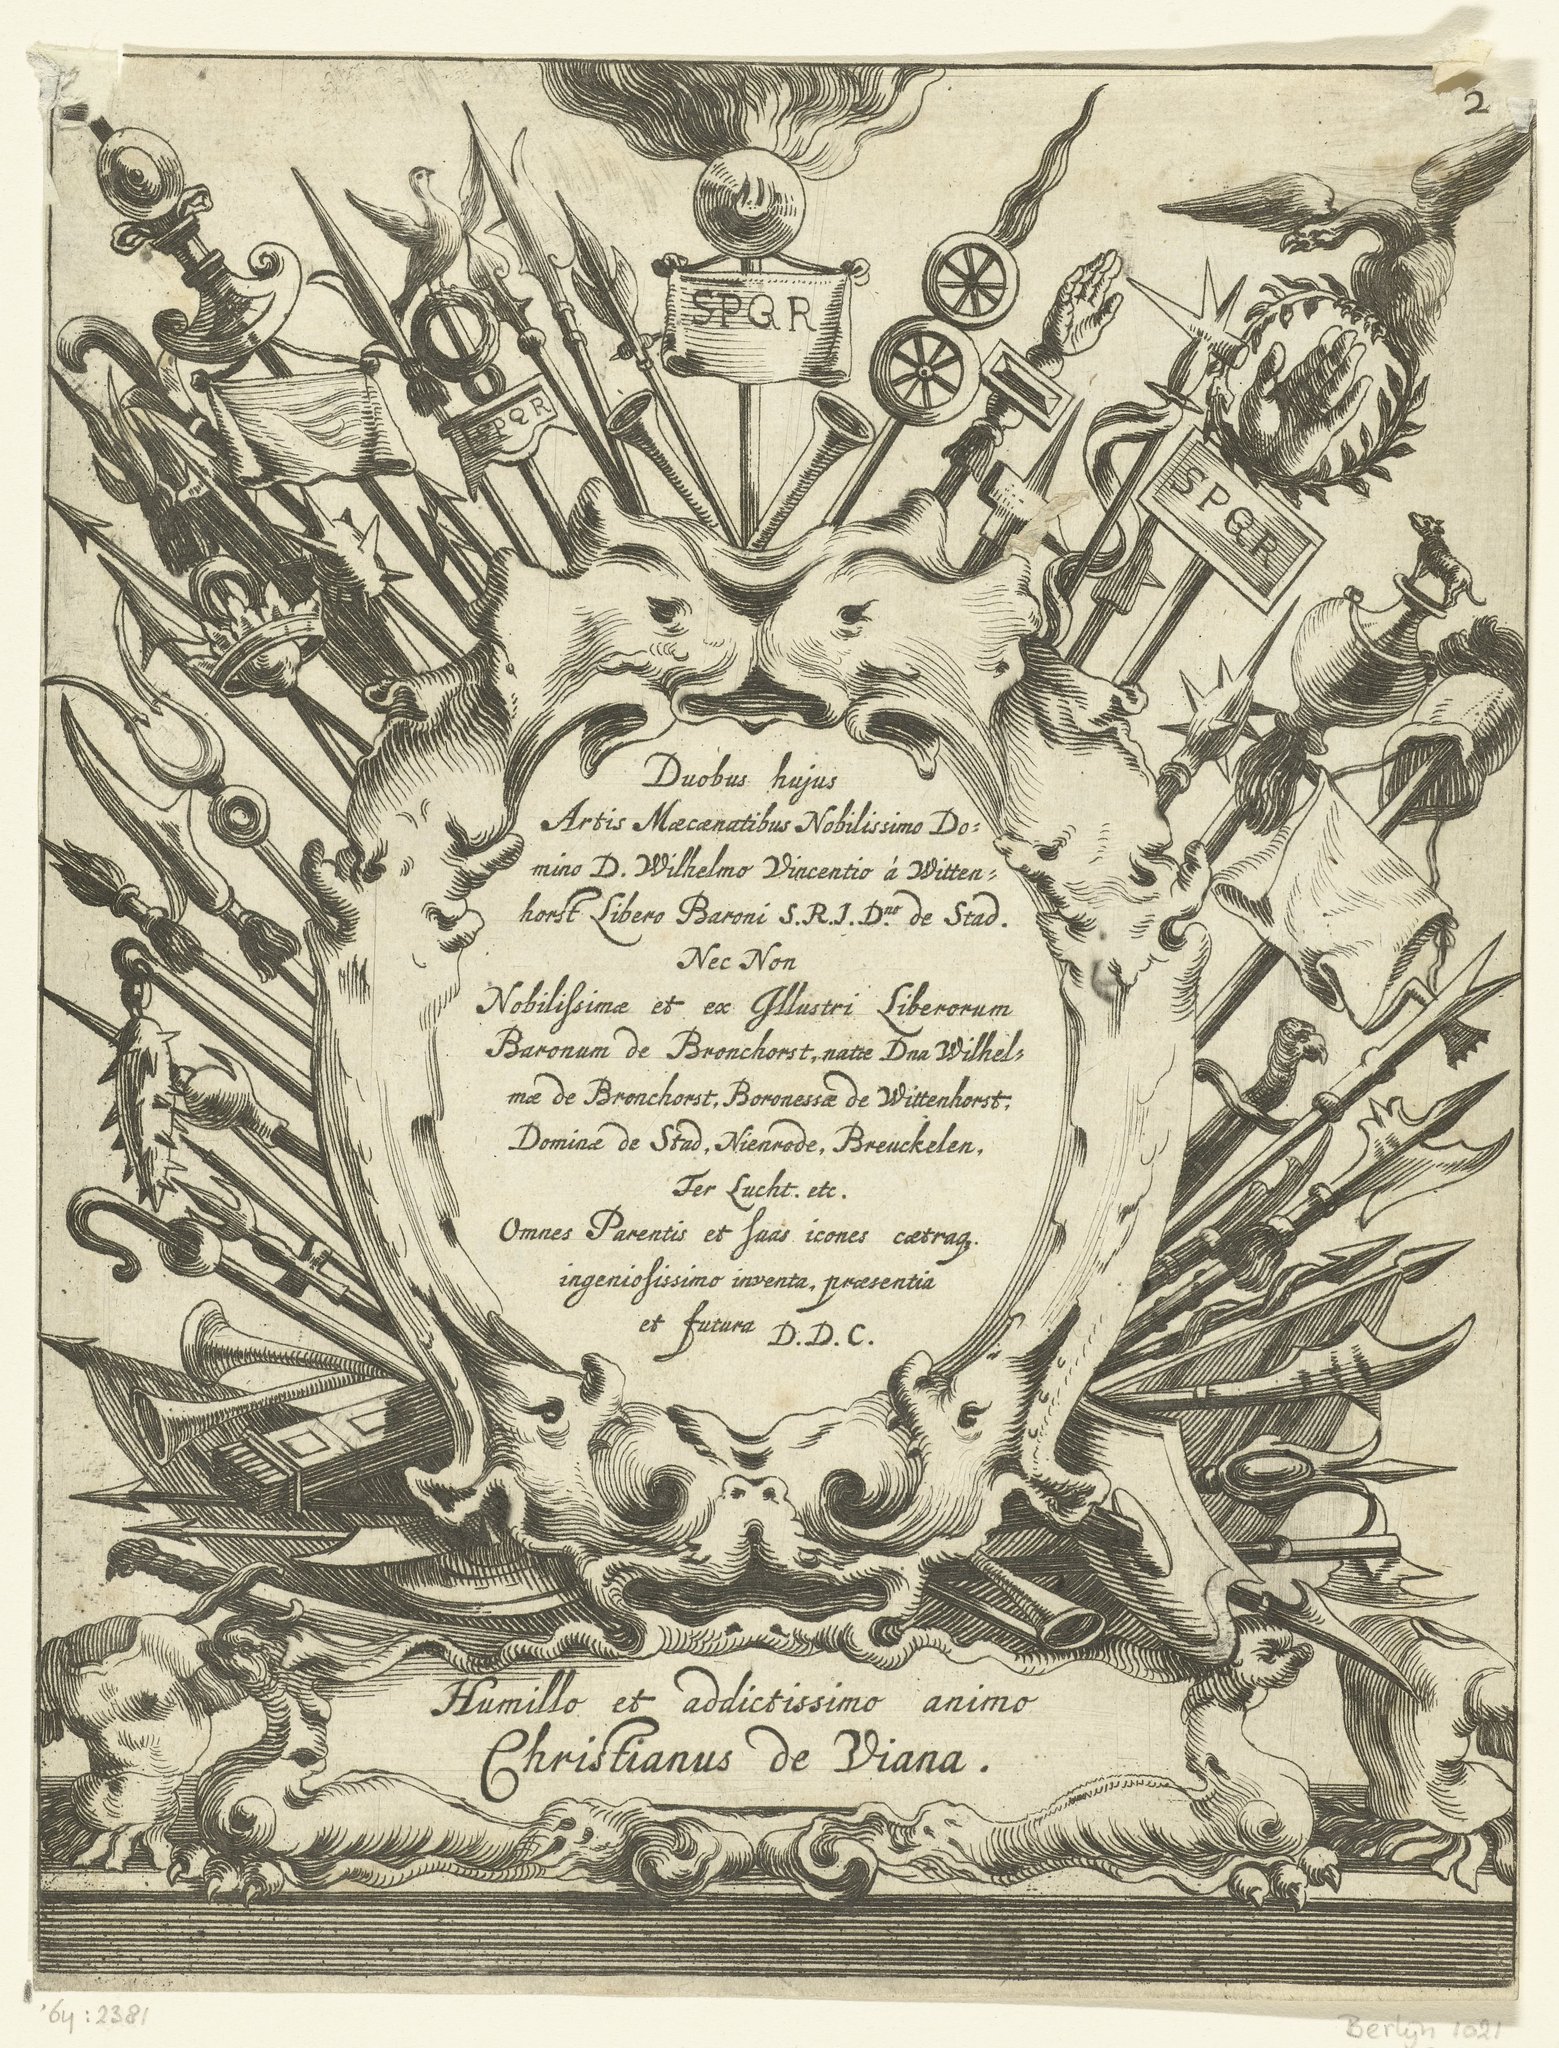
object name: print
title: Opdracht in kwabcartouche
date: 1646-1652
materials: paper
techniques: etching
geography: utrecht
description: De cartouche bestaat uit twee compartimenten, met op de achtergrond een wapentrofee.